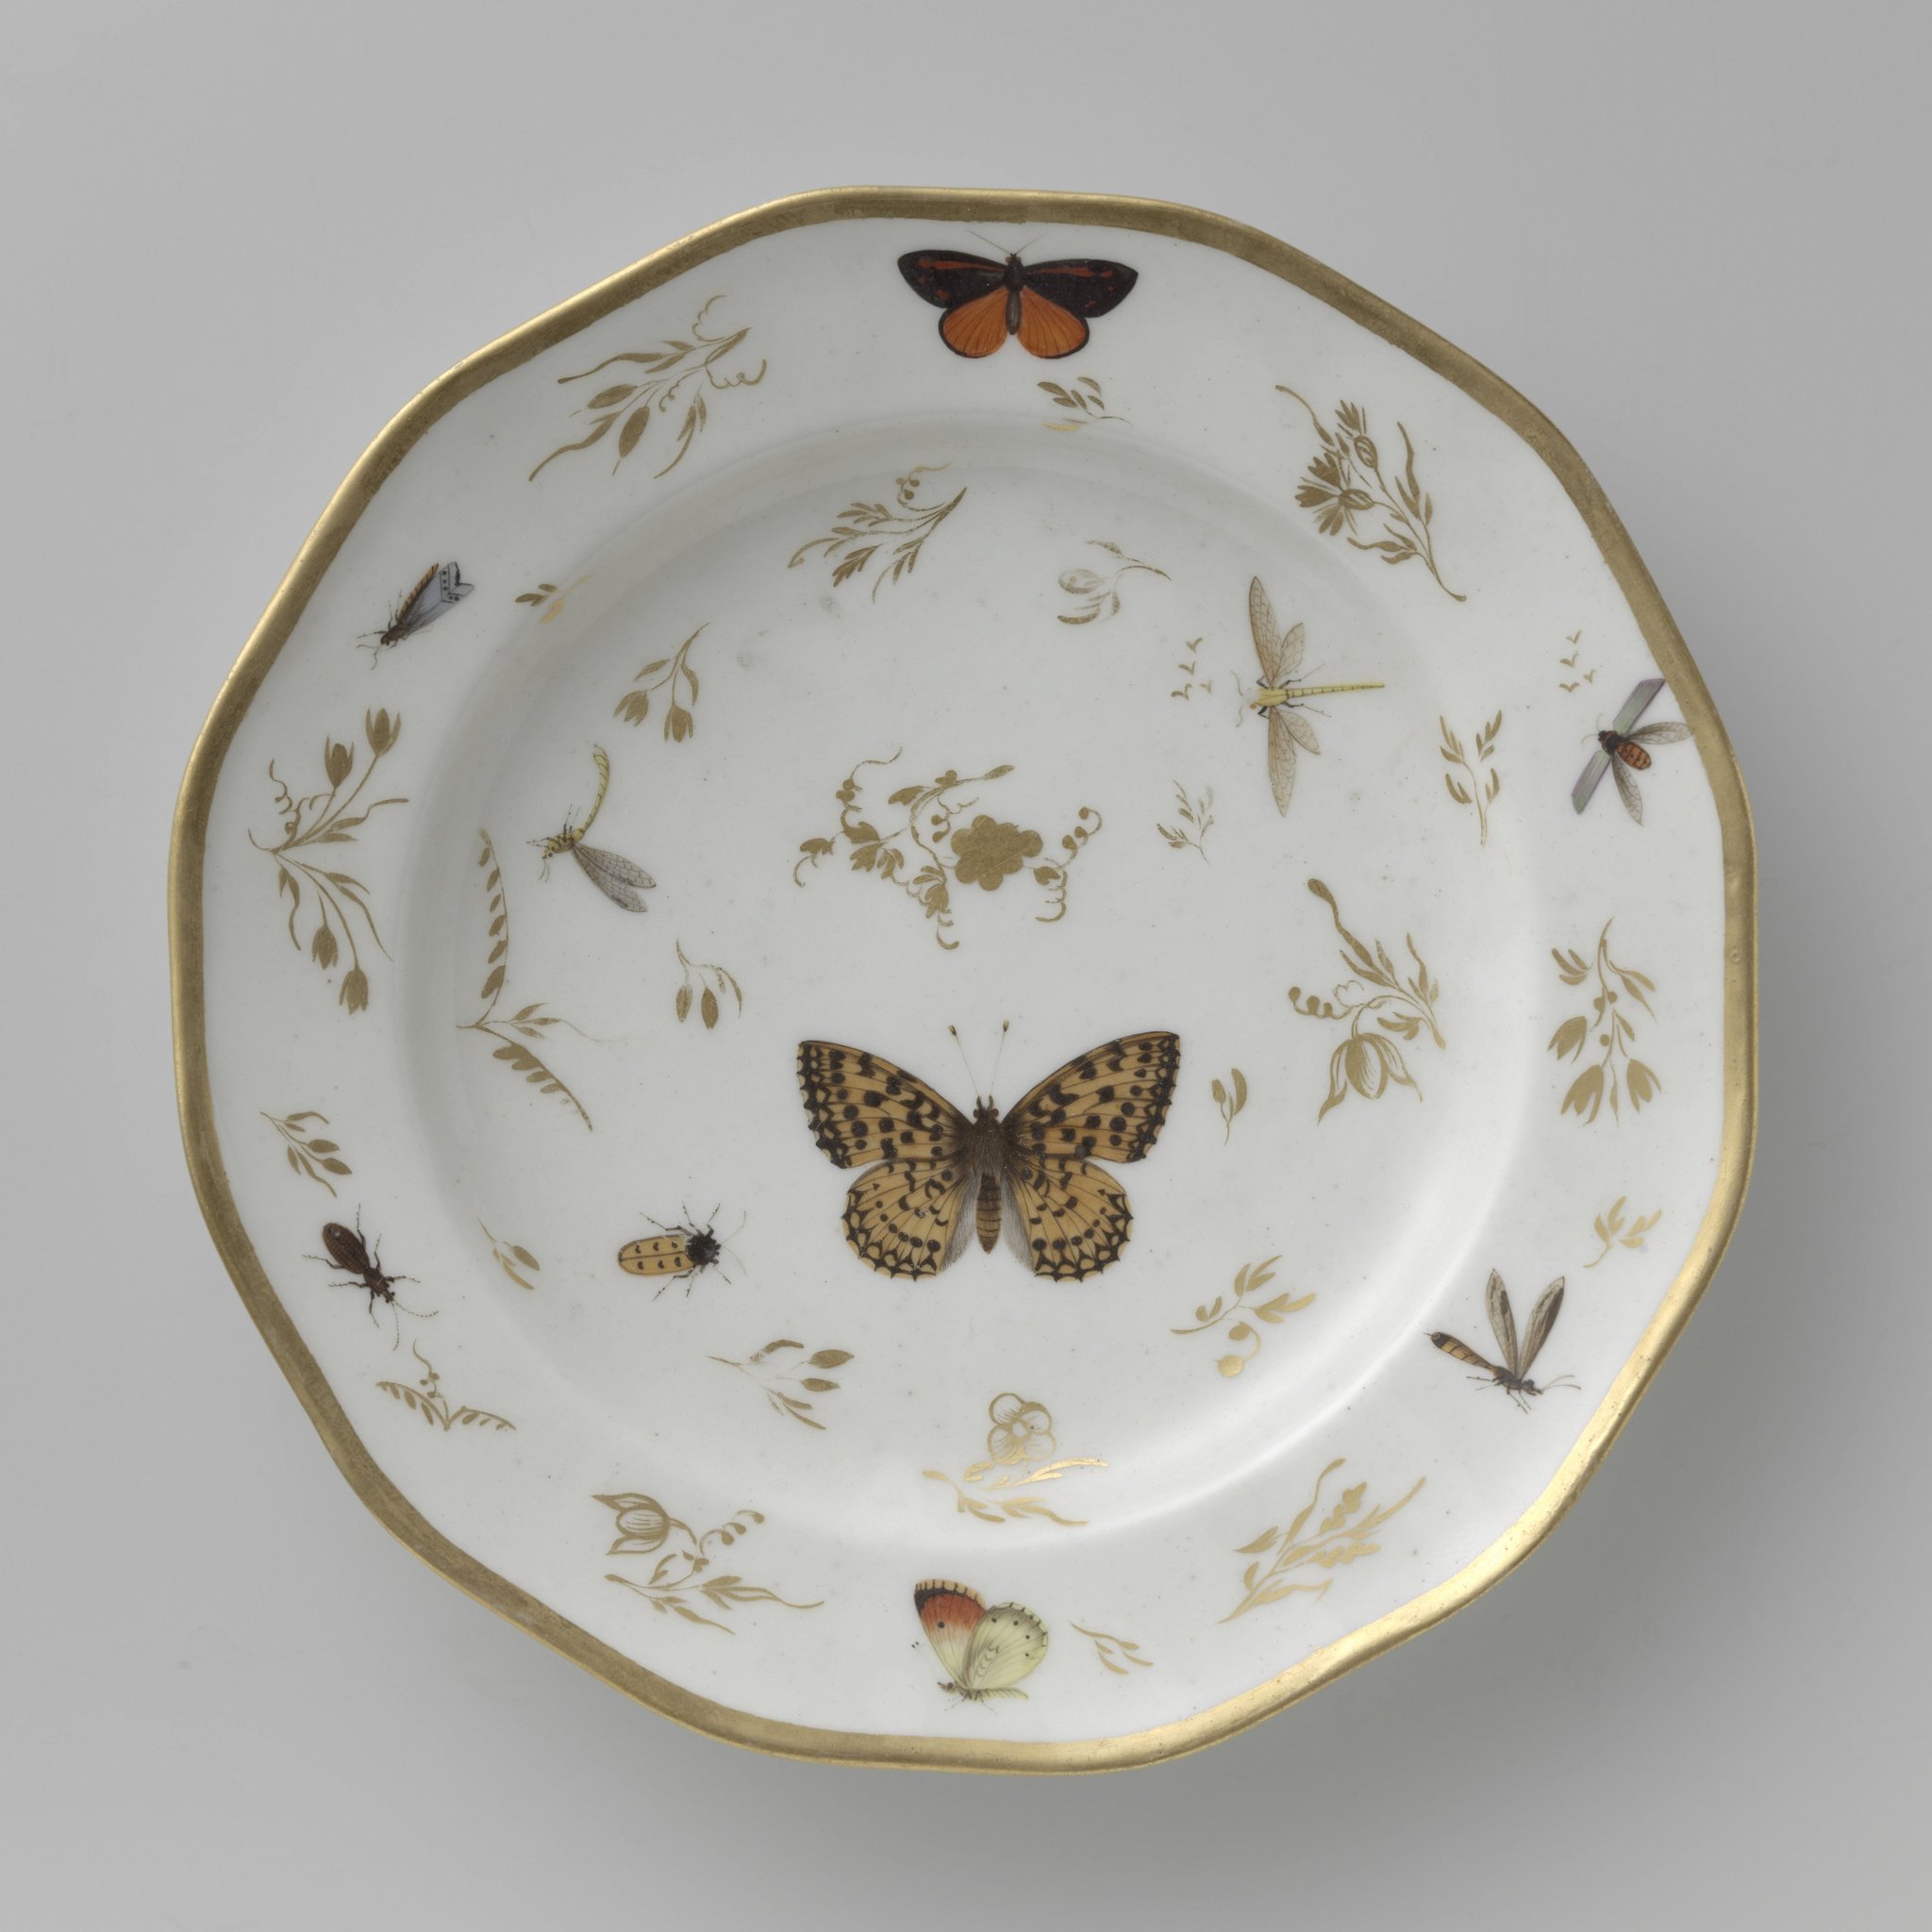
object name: service set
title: Plate with insects, flower sprays and grapevines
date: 1797-1798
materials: glaze, gold, paint, porcelain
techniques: firing, forming, gilding, turning, vitrification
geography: paris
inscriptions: mark: ‘GB/ Rue Thiroux/ à Paris’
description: Kop van porselein, deel van een theeservies, versierd met gouden randen, insecten in kleuren en gouden strooibloemen. Opmerking: sommige delen van het theeservies zijn gemerkt met de letters GB, Rue Thirou à Paris. Opmerking: verschillende koppen beschadigd; één met gebroken oor.